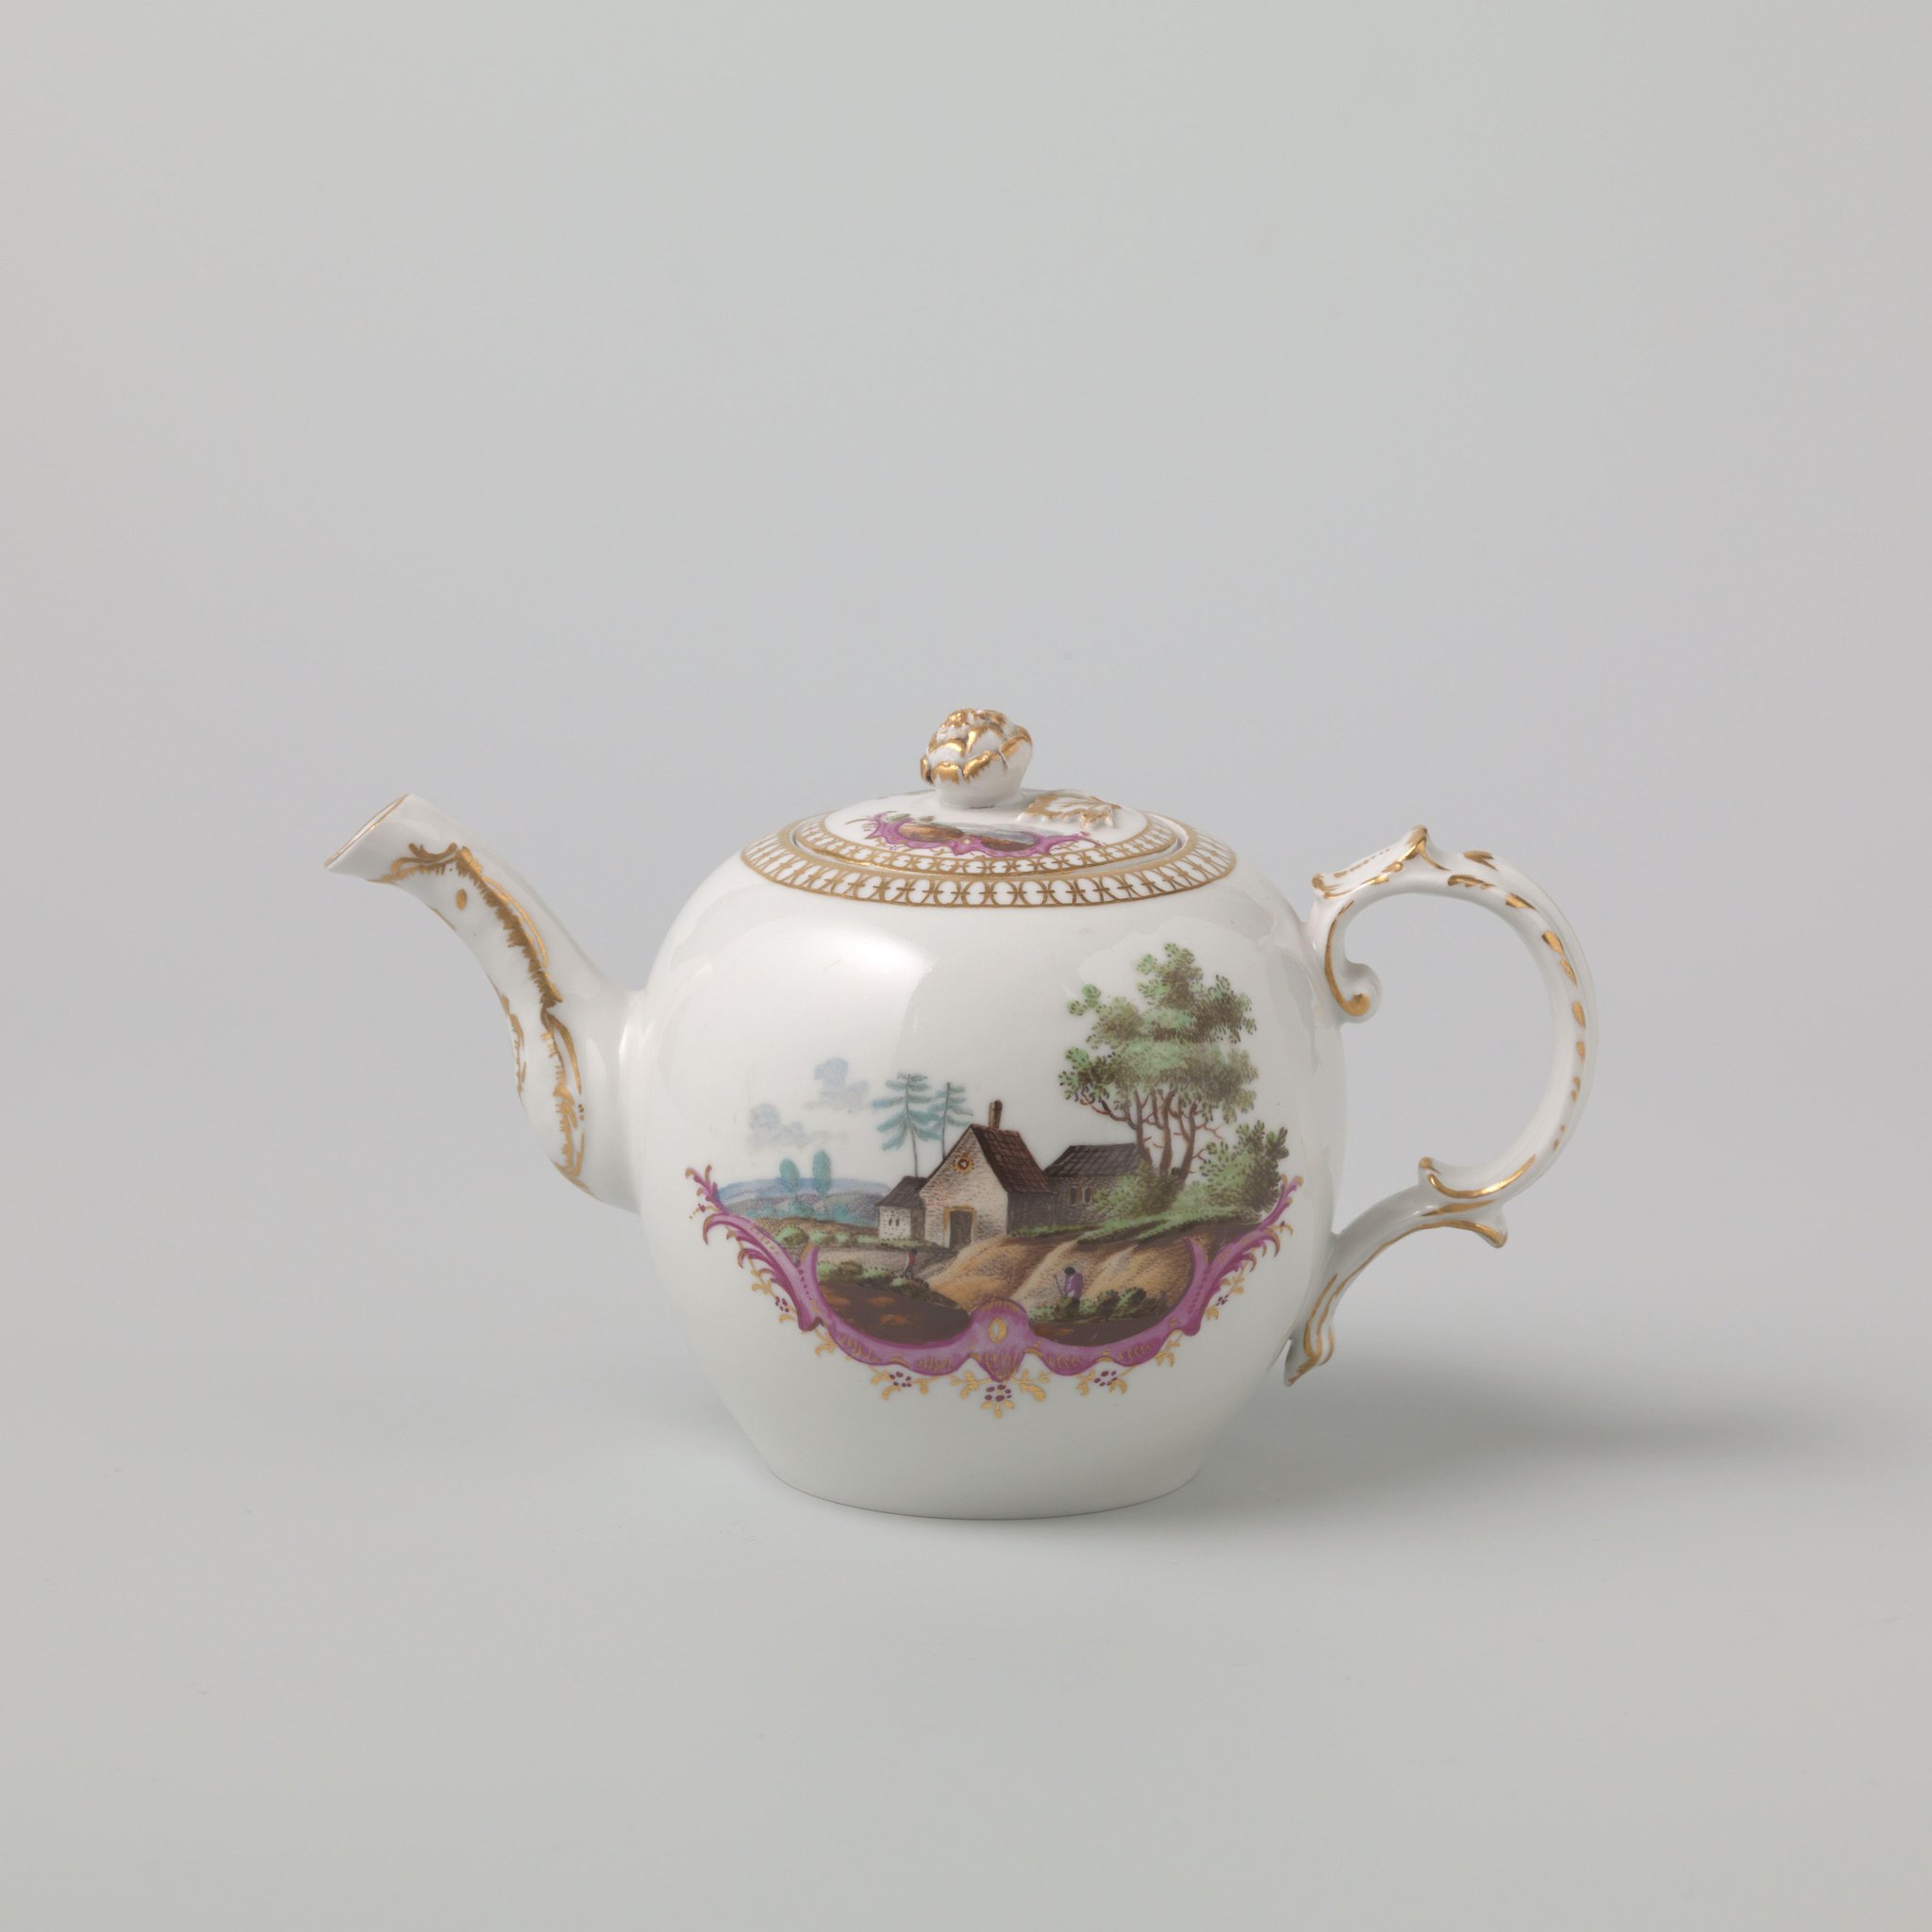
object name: teapot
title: Teapot with two landscapes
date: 1765-1775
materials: glaze, gold, paint, porcelain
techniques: firing, forming, gilding, turning, vitrification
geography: furstenberg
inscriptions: mark: ‘F/ 3/ B3’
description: Tea pot. Porcelain Fürstenberg, c. 1765 - 1775.